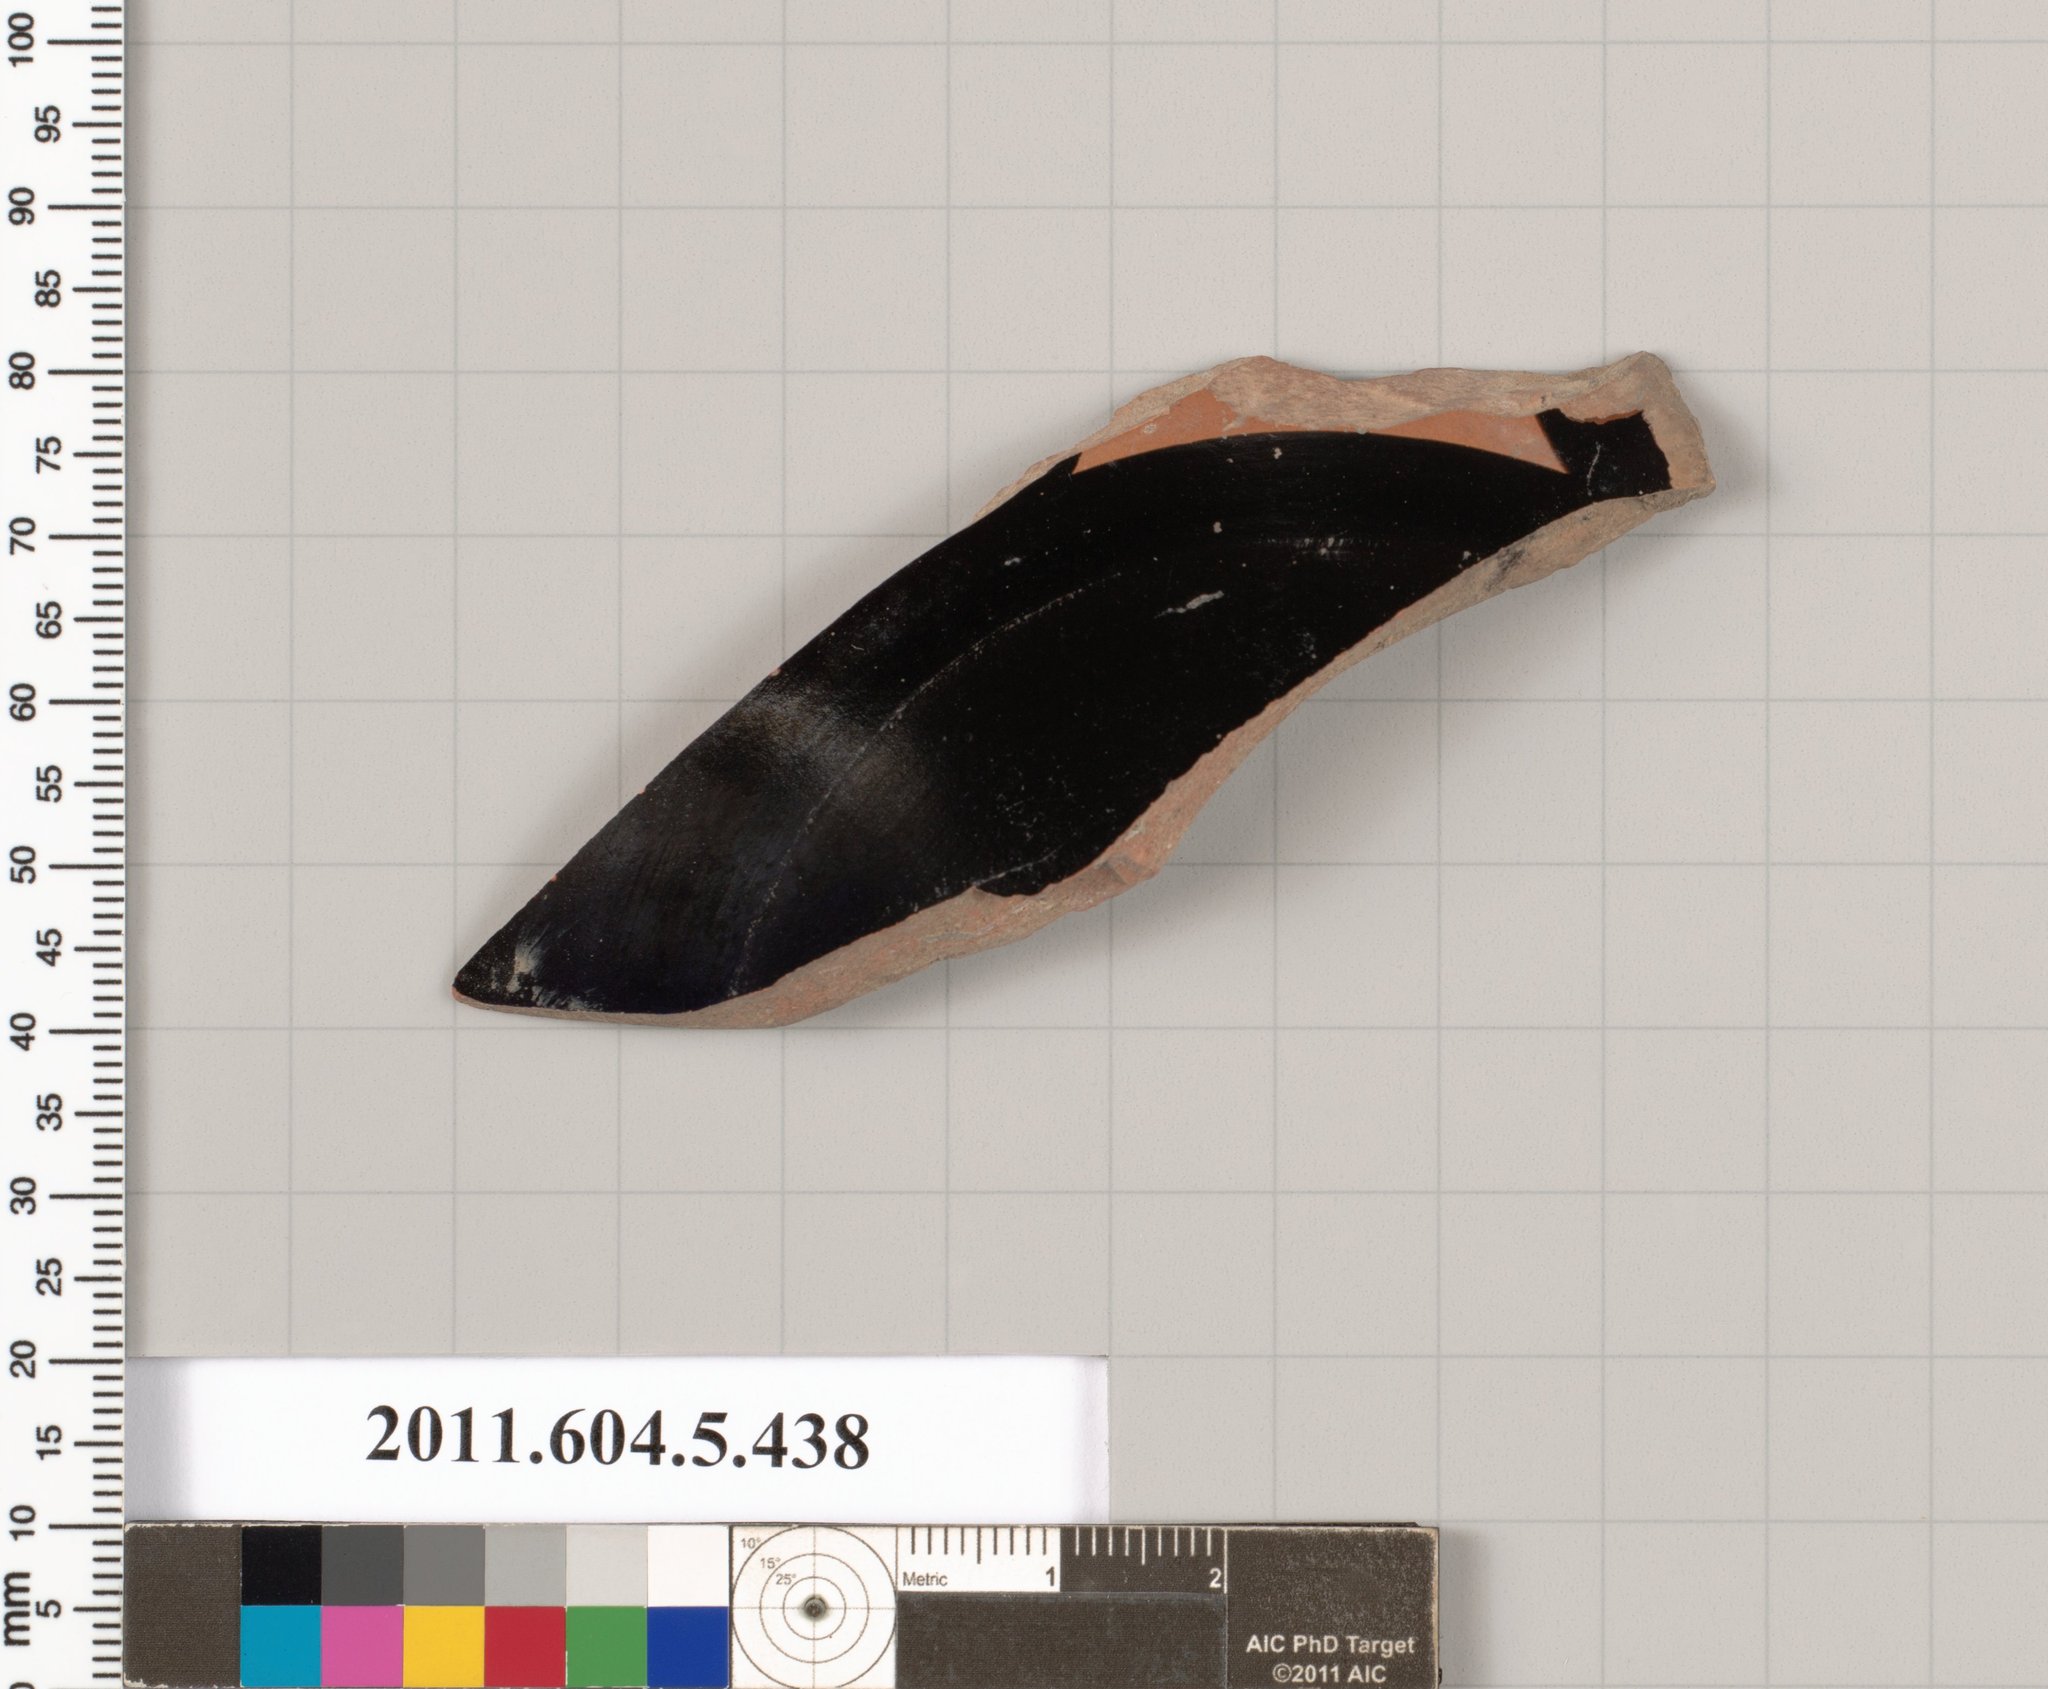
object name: kylix fragment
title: Terracotta fragment of a kylix (drinking cup)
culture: greek, attic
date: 600-401 BCE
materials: terracotta